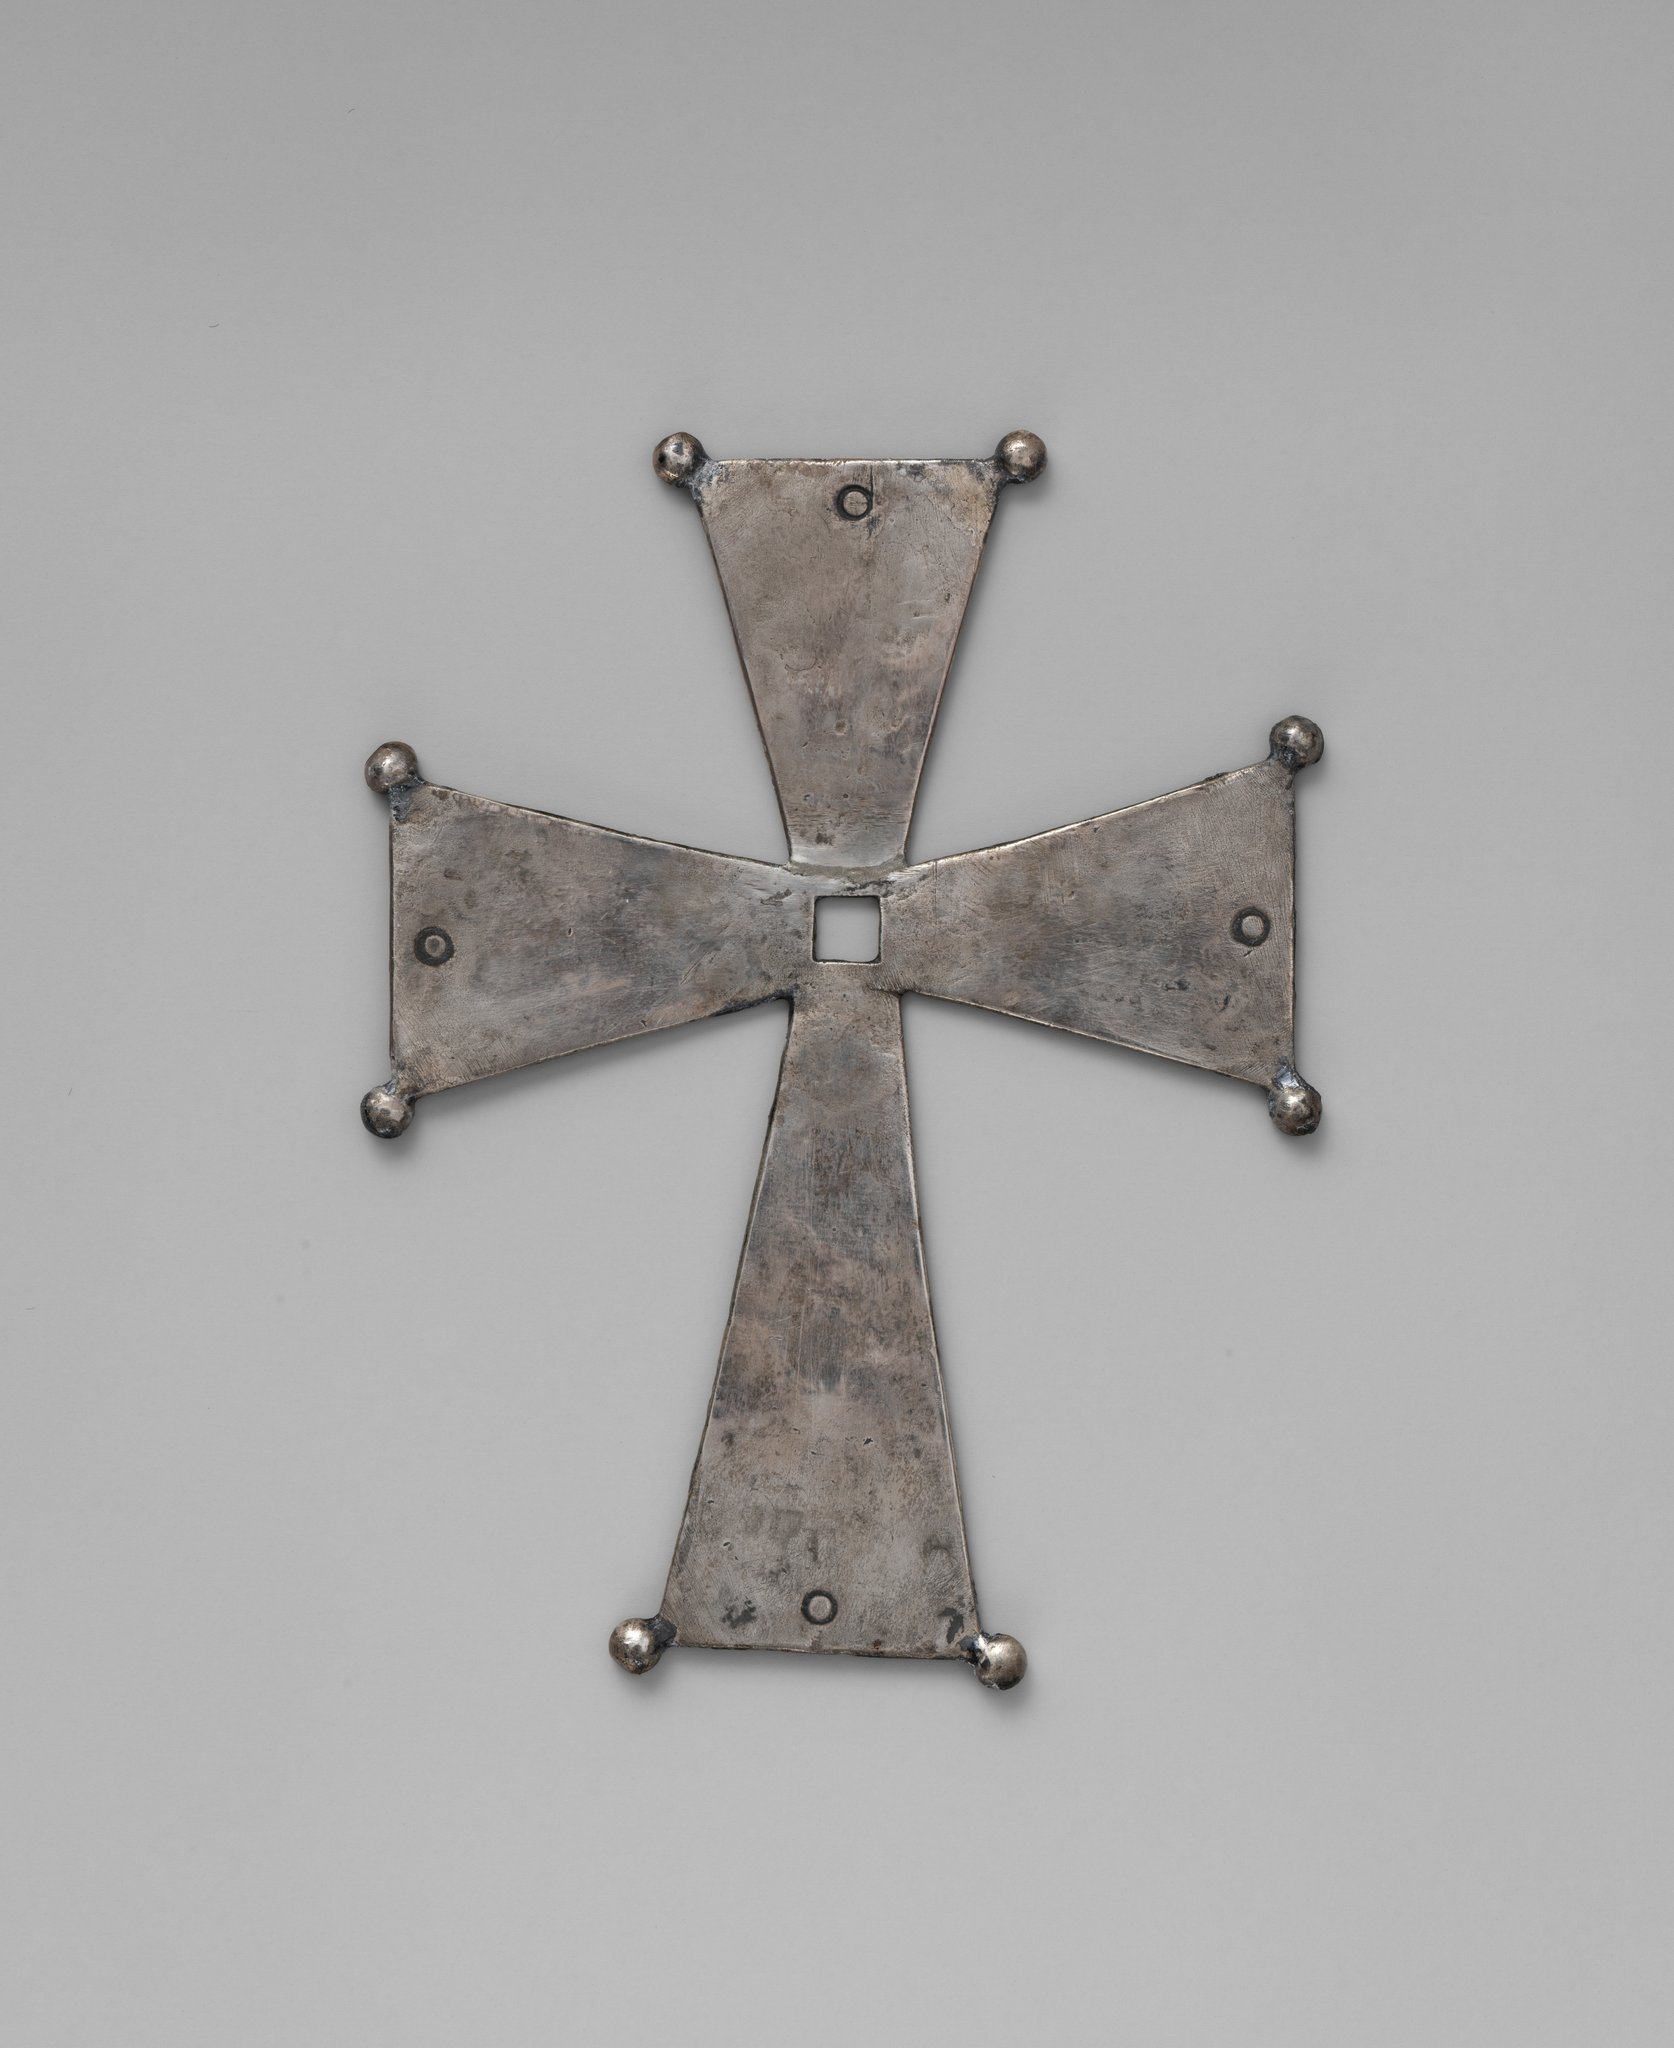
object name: cross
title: Silver Cross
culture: byzantine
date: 500-700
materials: niello, silver